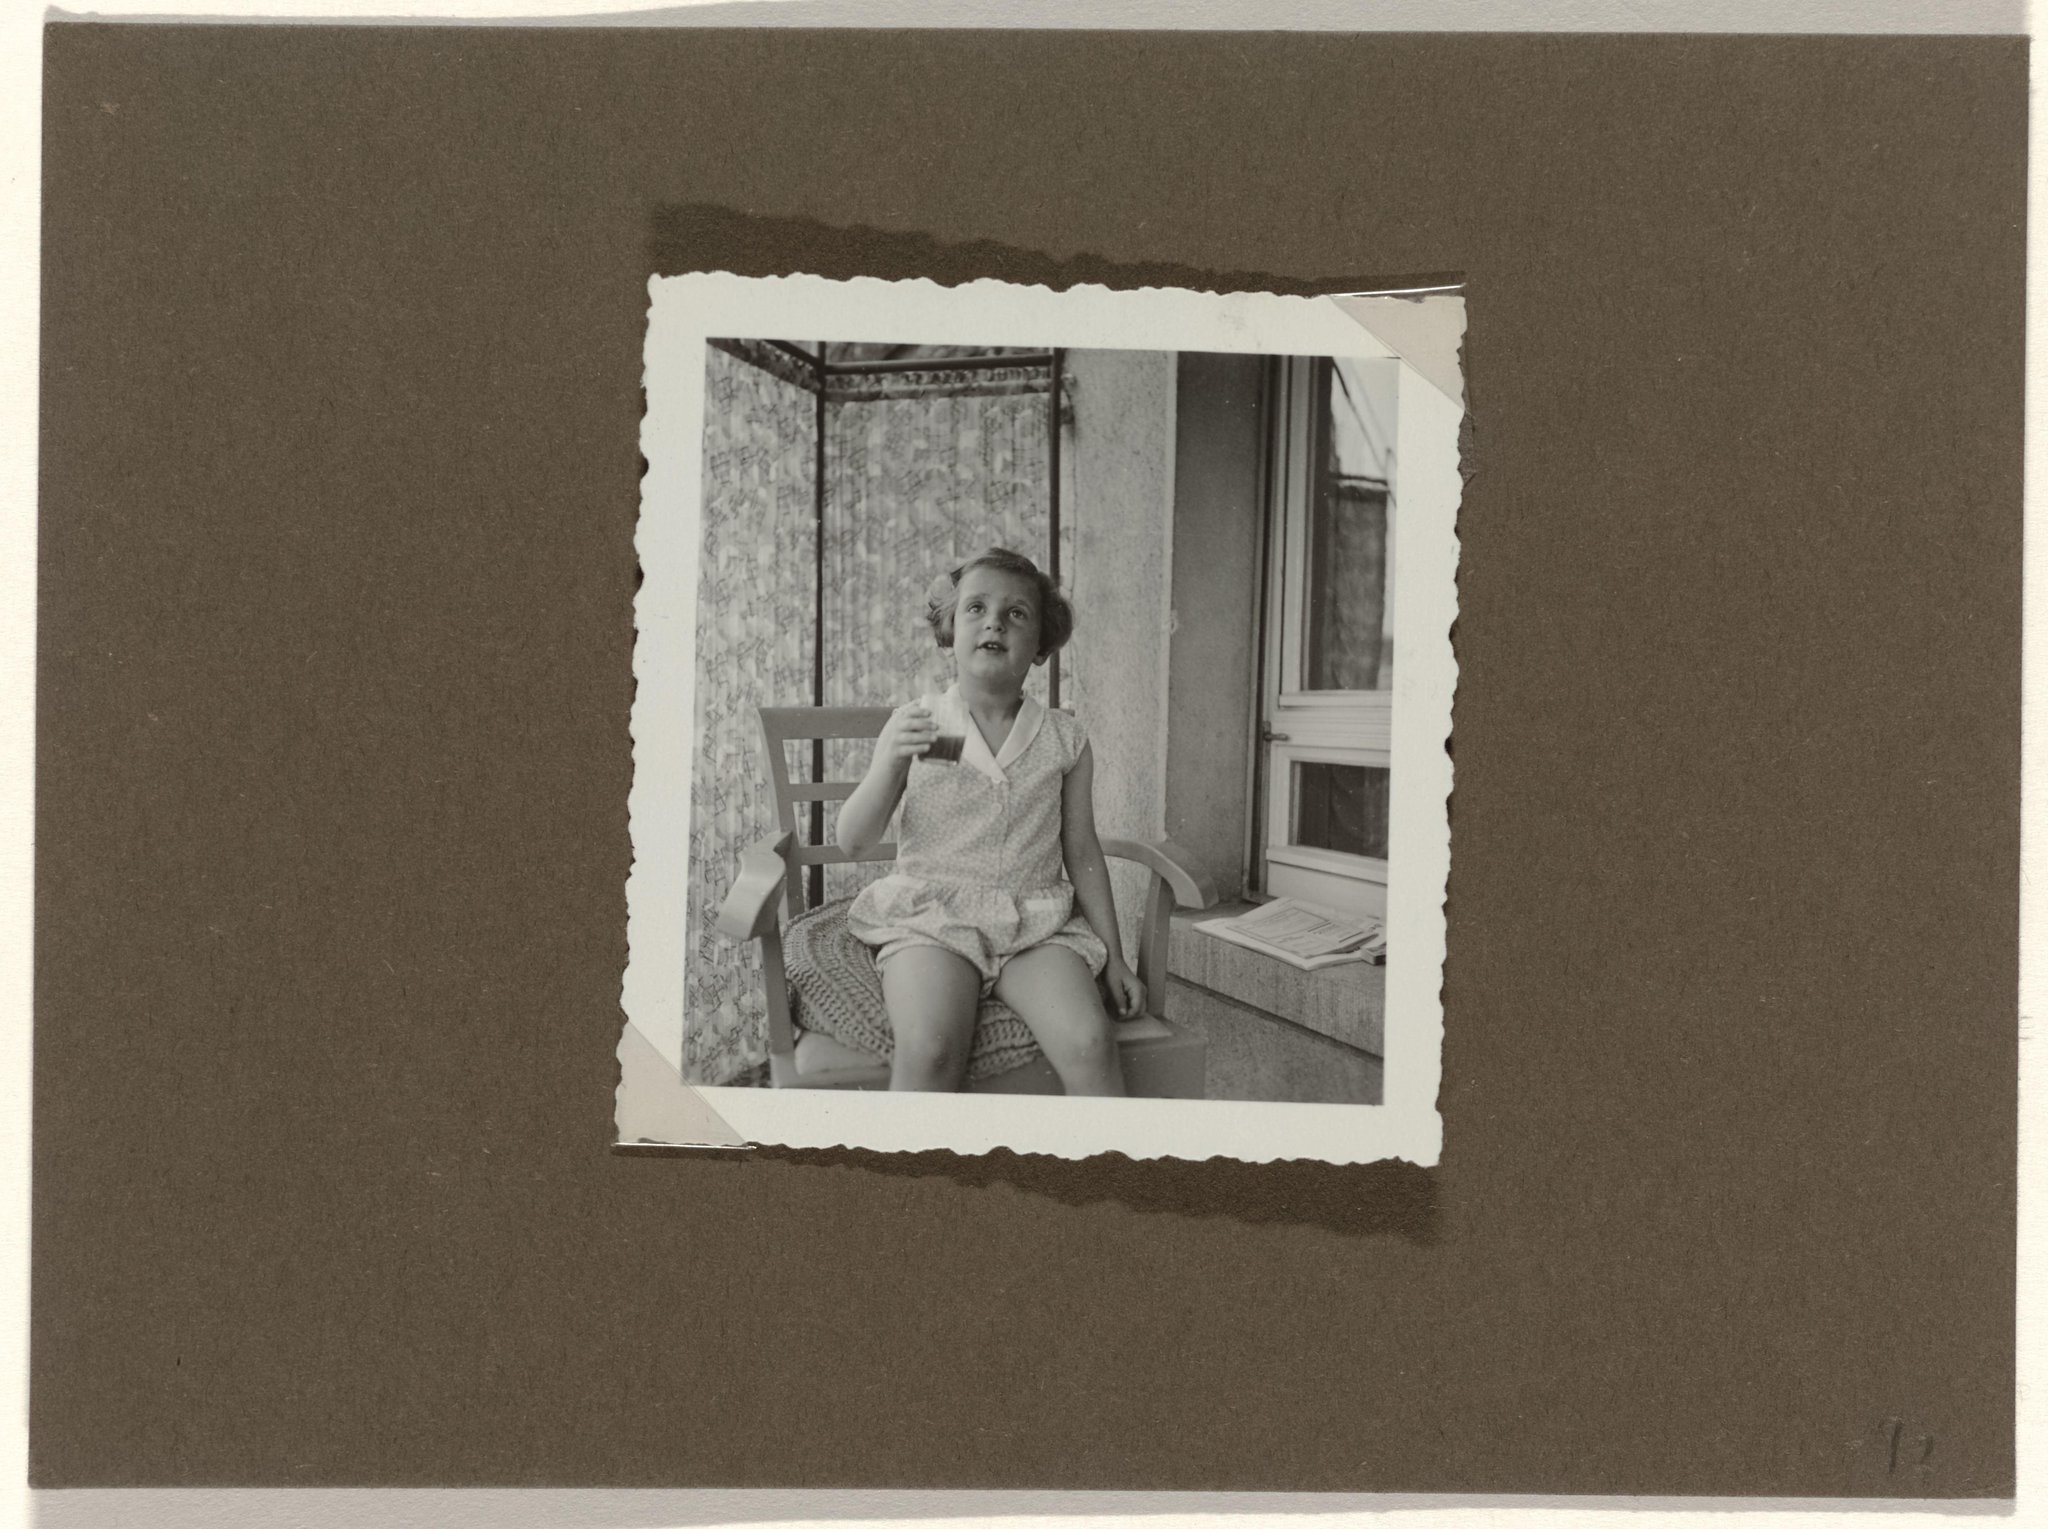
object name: photograph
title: Isabel Wachenheimer in een stoel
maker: Anonymous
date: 1905-1934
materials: photographic support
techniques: gelatin silver print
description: Dit object is onderdeel van de nalatenschap van Isabel Elon-Wachenheimer (1928-2010). Tot haar overlijden behoorde het samen met de andere objecten uit de nalatenschap tot haar privédomein van Isabel Wachenheimer. In die particuliere context zijn deze objecten tezamen en individueel aandenkens - aan de jeugd, ouders en familie van Isabel Wachenheimer vóór en tijdens de Shoah en aan haar leven na de Tweede Wereldoorlog. Isabel Wachenheimer, die van juni 1943 tot mei 1945 gevangen zat in Kamp Westerbork, Theresienstadt, Auschwitz, Lenzing a/d Oberdonau (een buitenkamp van Mauthausen), overleefde de Shoah. Haar ouders – Eugène Wachenheimer en Else Wachenheimer-Moos - werden op 14 oktober 1944 in Auschwitz-Birkenau vermoord.